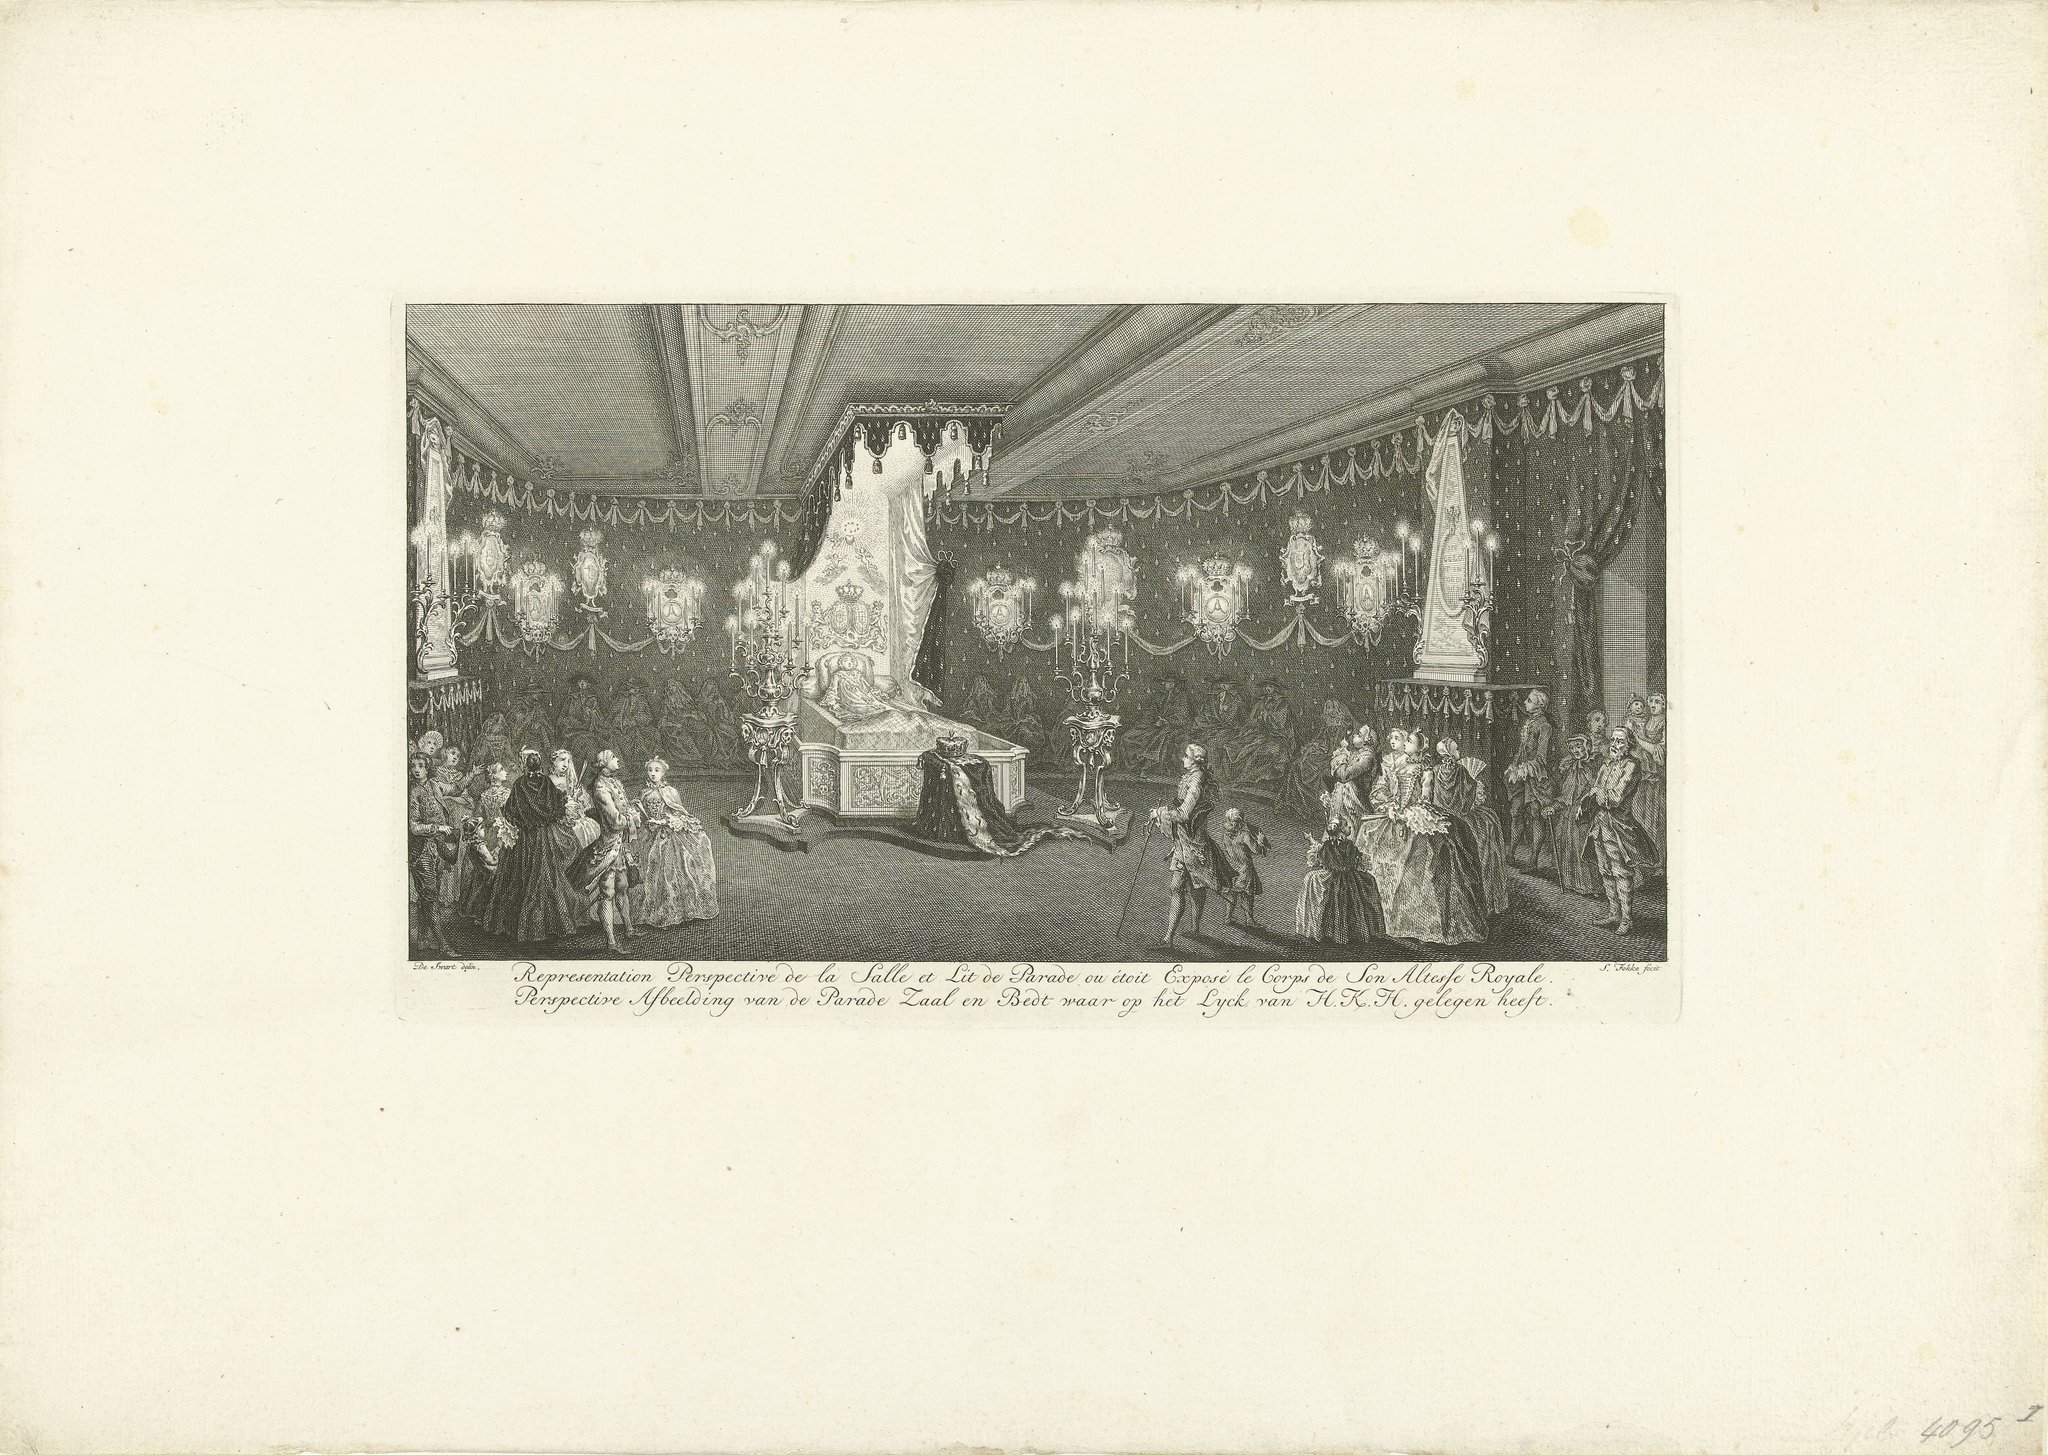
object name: print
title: Praalbed van prinses Anna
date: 1759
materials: paper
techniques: engraving, etching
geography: northern netherlands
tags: william v (prince of orange), carolina (prinses van oranje-nassau), anna van hannover, lying in state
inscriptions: collector's mark: Lugt 2228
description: Paradezaal met het praalbed en bezoekers. Onderdeel van een serie van vier platen van het praalbed waarop de op 12 januari 1759 overleden prinses Anna van Hannover gedurende enkele dagen in februari opgebaard heeft gelegen.